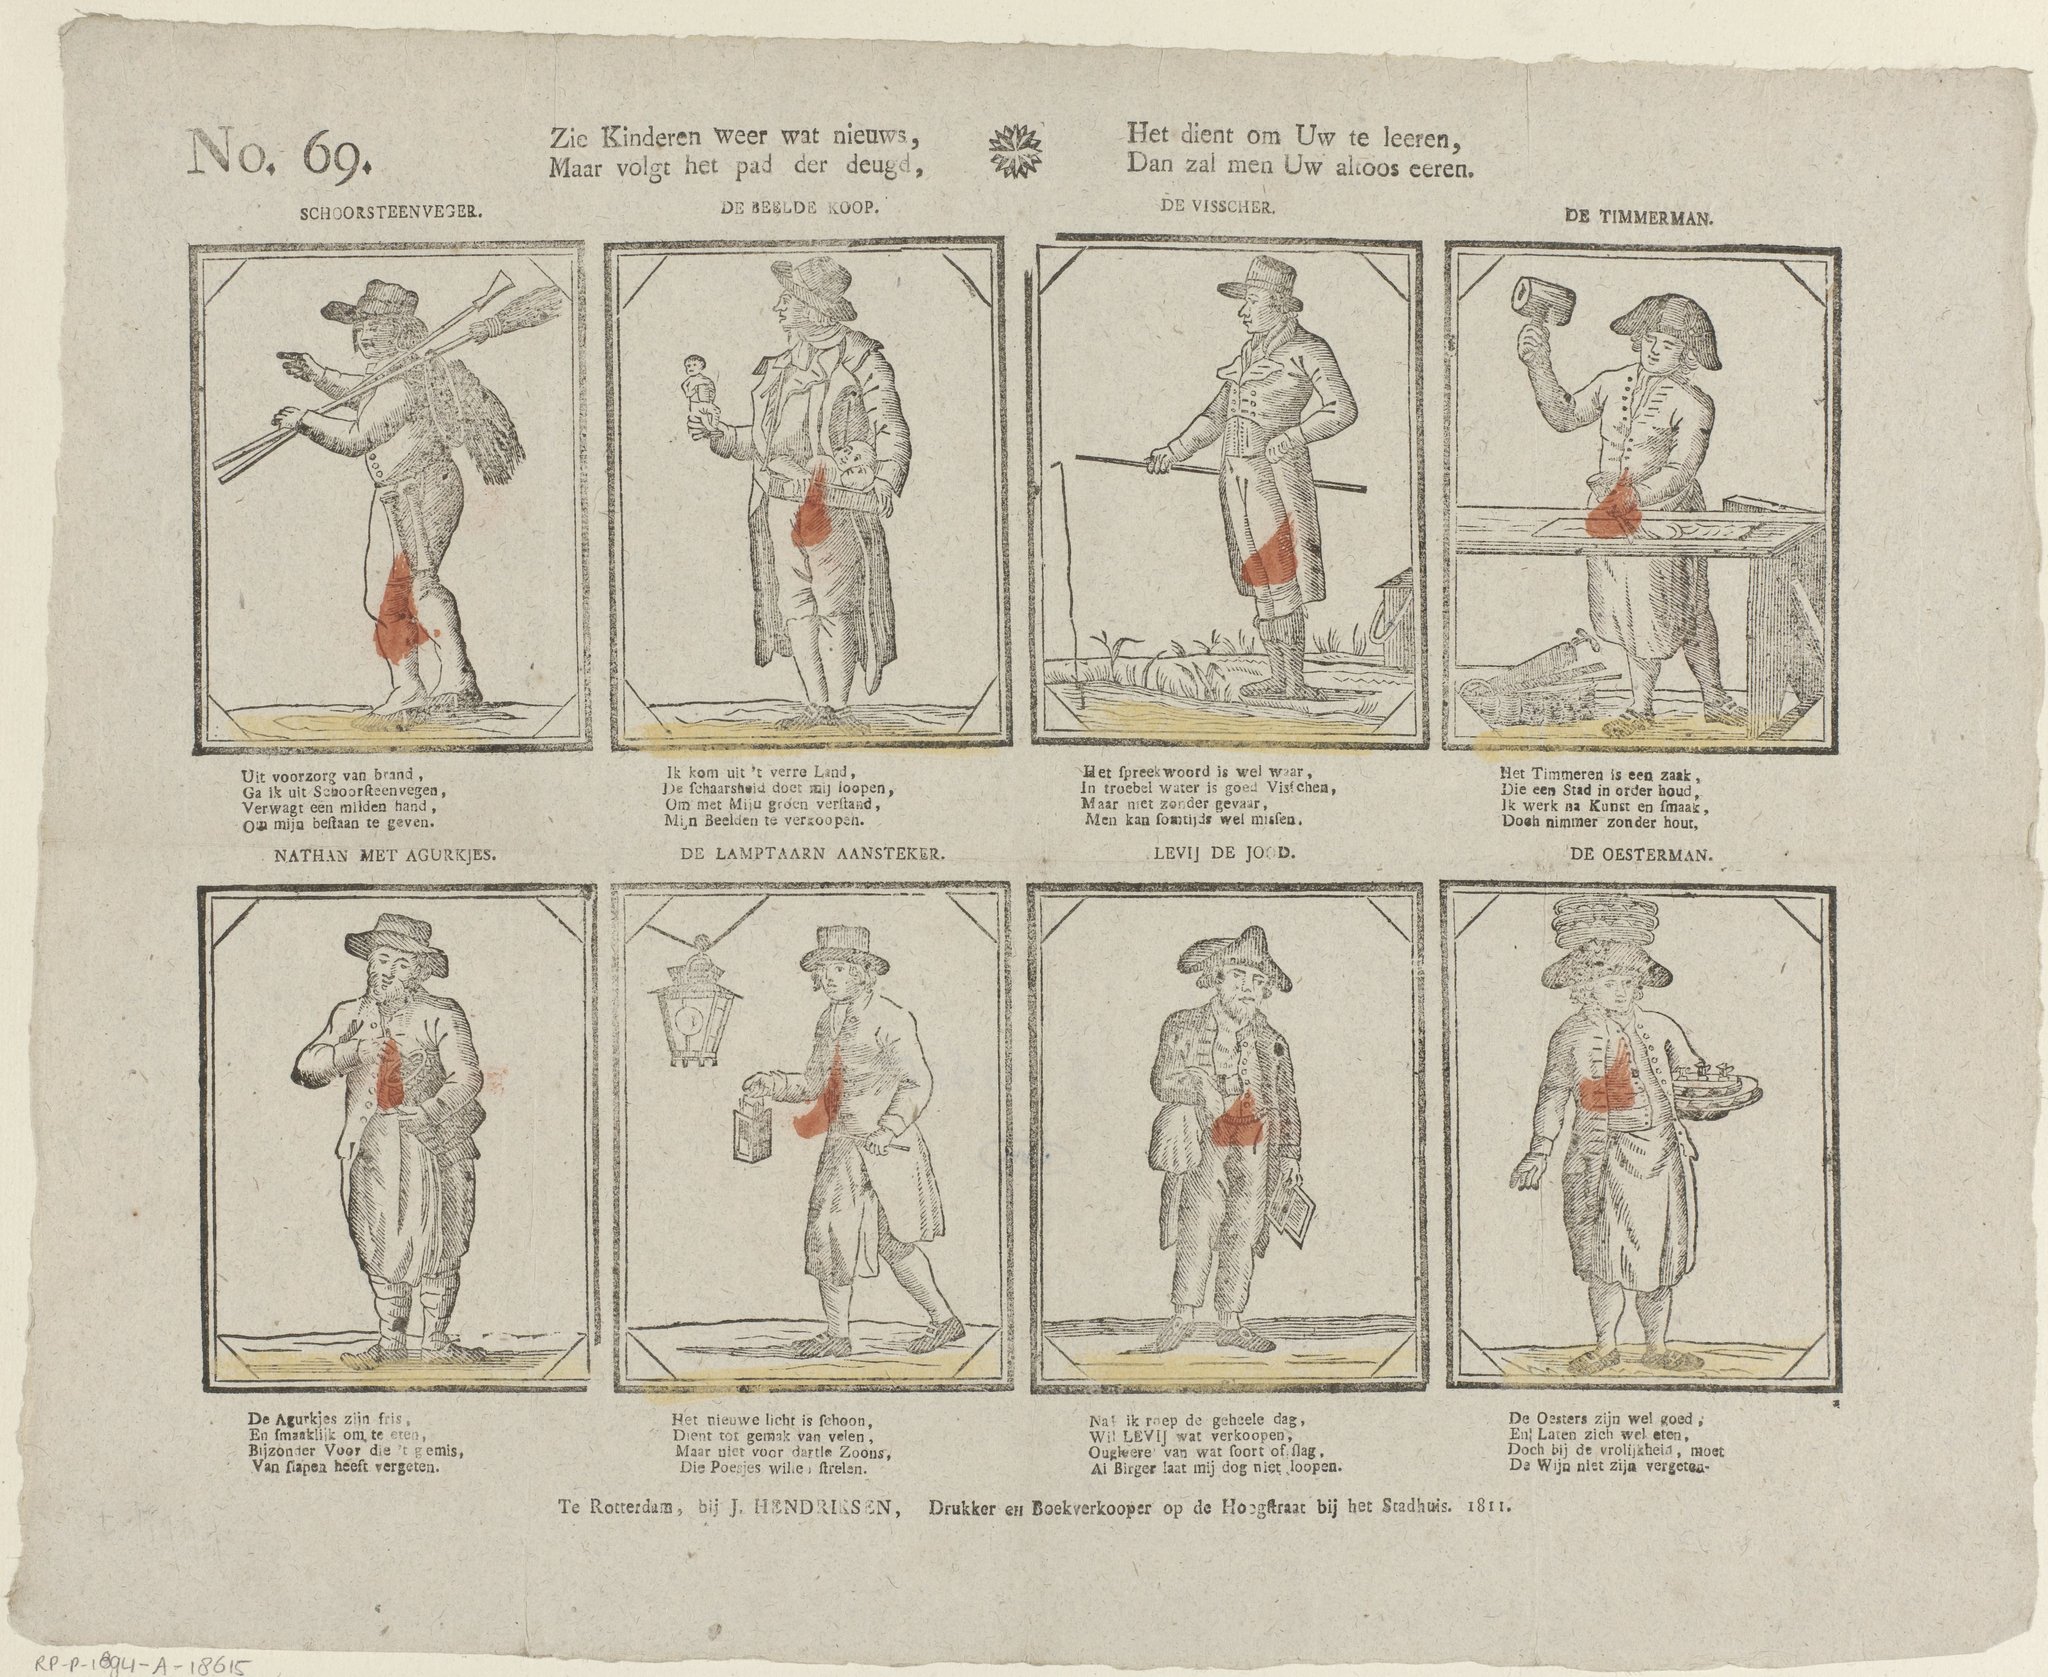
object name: popular print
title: Zie kinderen weer wat nieuws, / Maar volgt het pad der deugd, / Het dient om uw te leeren, / Dan zal men uw altoos eeren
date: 1811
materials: paper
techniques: colour, letterpress printing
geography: rotterdam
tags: carpenter, street-trader, handicrafts ~ maintenance and repair (with name of trade or profession), fisherman, merchant, salesman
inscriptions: collector's mark: Lugt 2228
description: Blad met 4 voorstellingen van ambachtslieden en beroepen, zoals schoorsteenveger, visser en lantaarnaansteker. Onder elke afbeelding een vierregelig vers. Genummerd linksboven: No. 69.